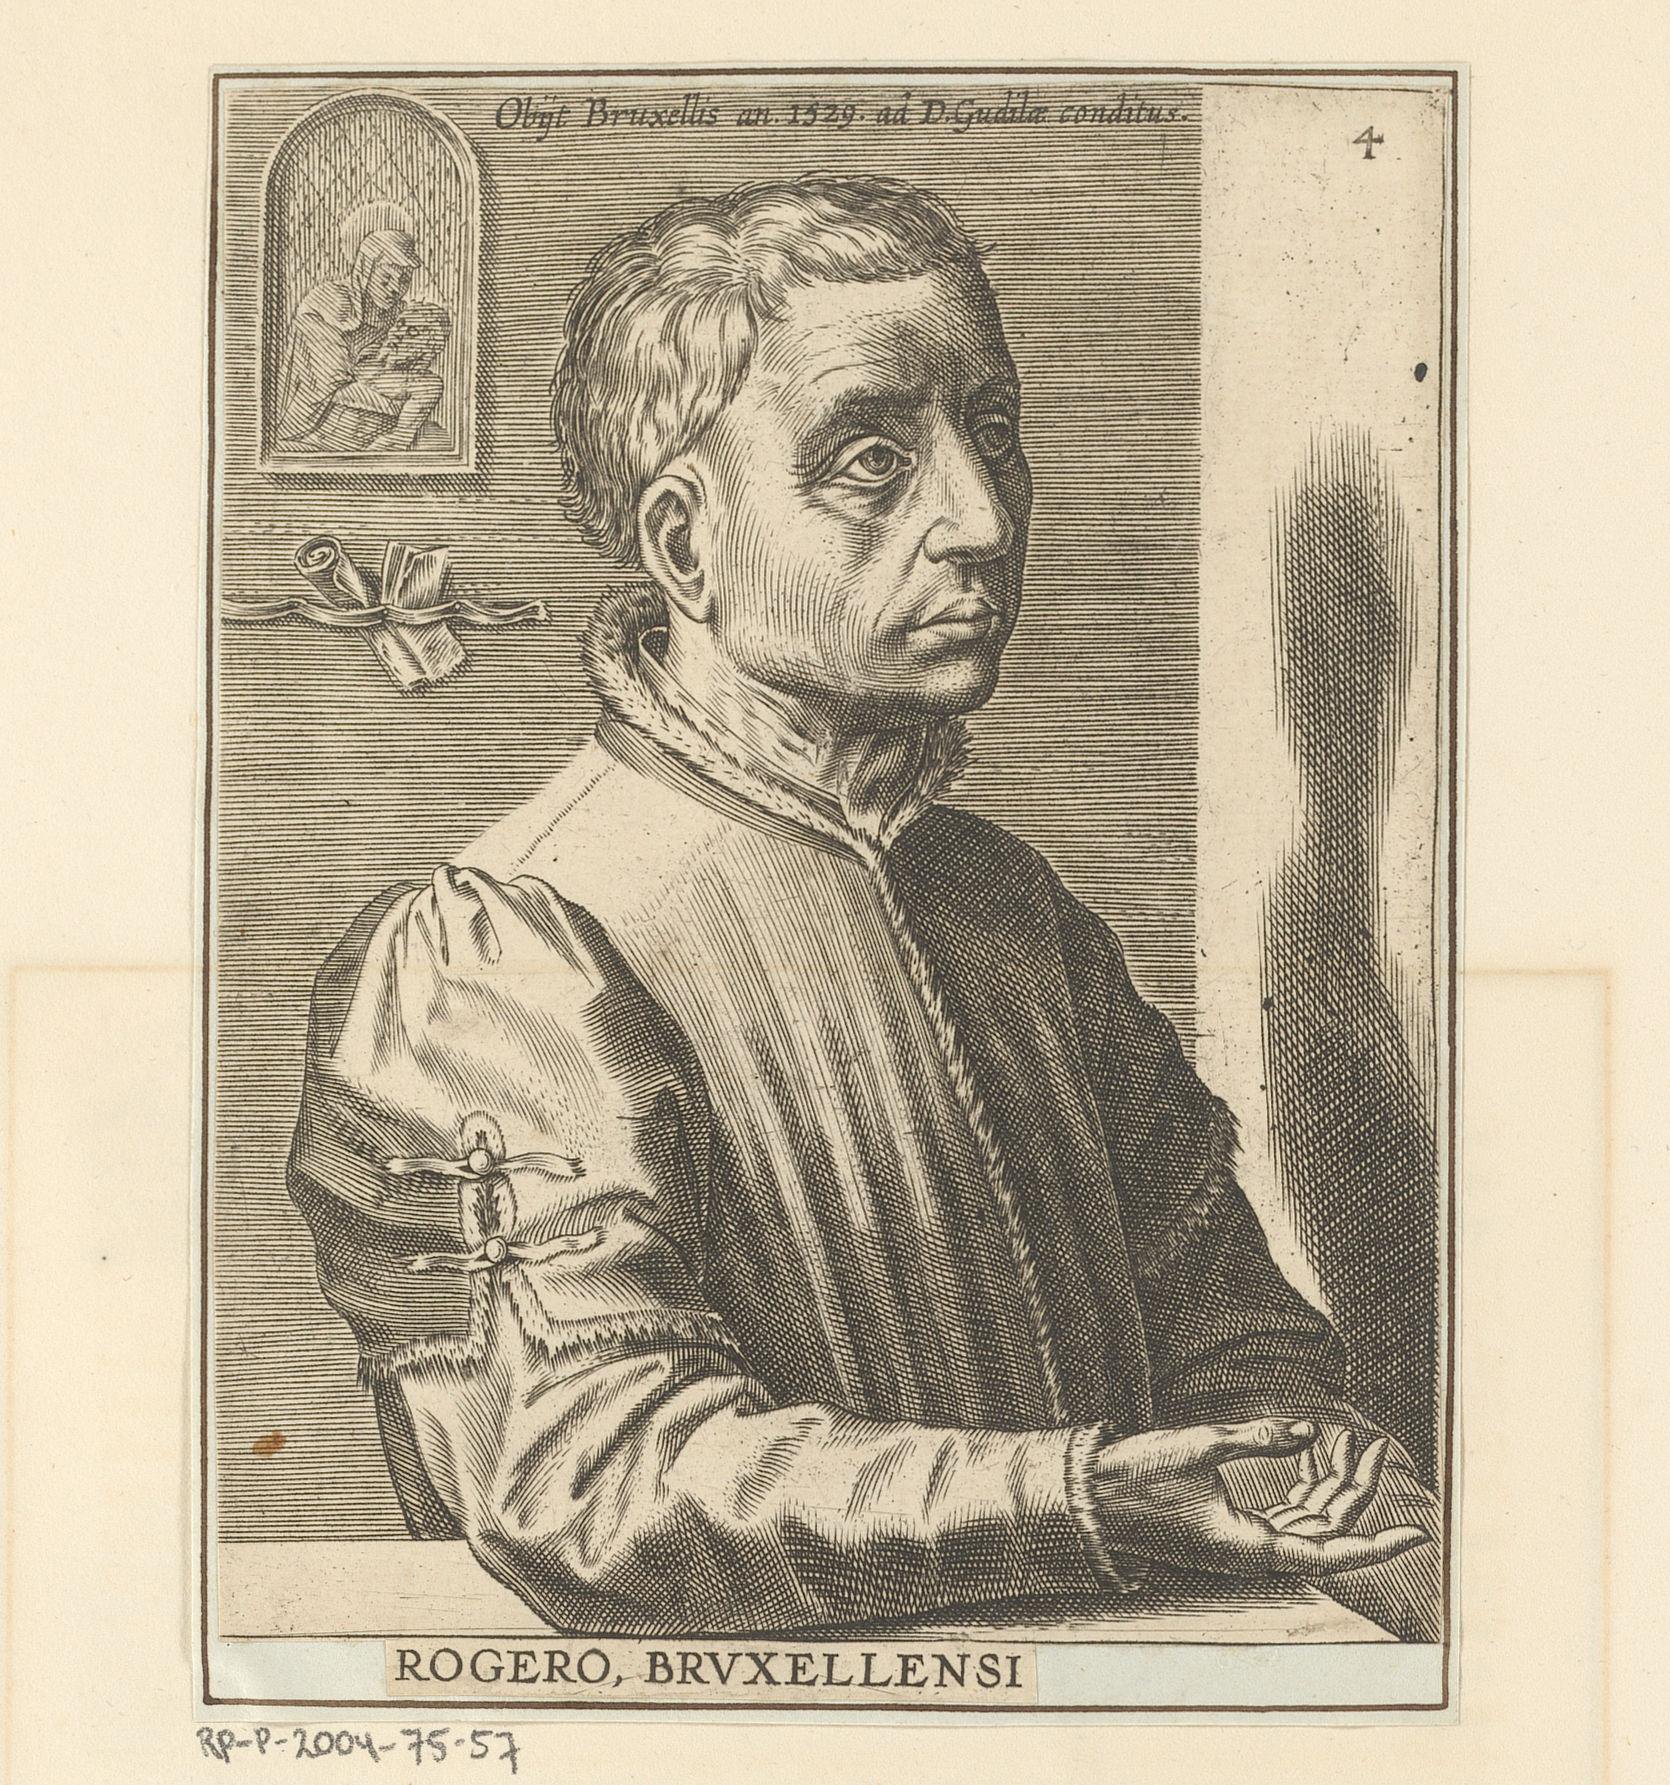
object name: print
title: Portretten van Belgische schilders naar het leven getekend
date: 1600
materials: paper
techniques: engraving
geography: antwerp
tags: brussels, painter, rogier van der weyden, historical persons, portrait, self-portrait of painter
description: Prentserie uitgegeven in boekvorm: Illustrium quos Belgium habuit pictorum effigies ad vivum accurate delineatae. Antwerpen: Theodoor Galle, [1600], p. 4. De samensteller heeft deze prent in het album geplakt als illustratie bij: Pilkington, Matthew en Johann Heinrich Füssli. A dictionary of painters, from the revival of the art to the present period. 4 dln. Londen: John Crowder, 1805, dl. 4, p. 645.